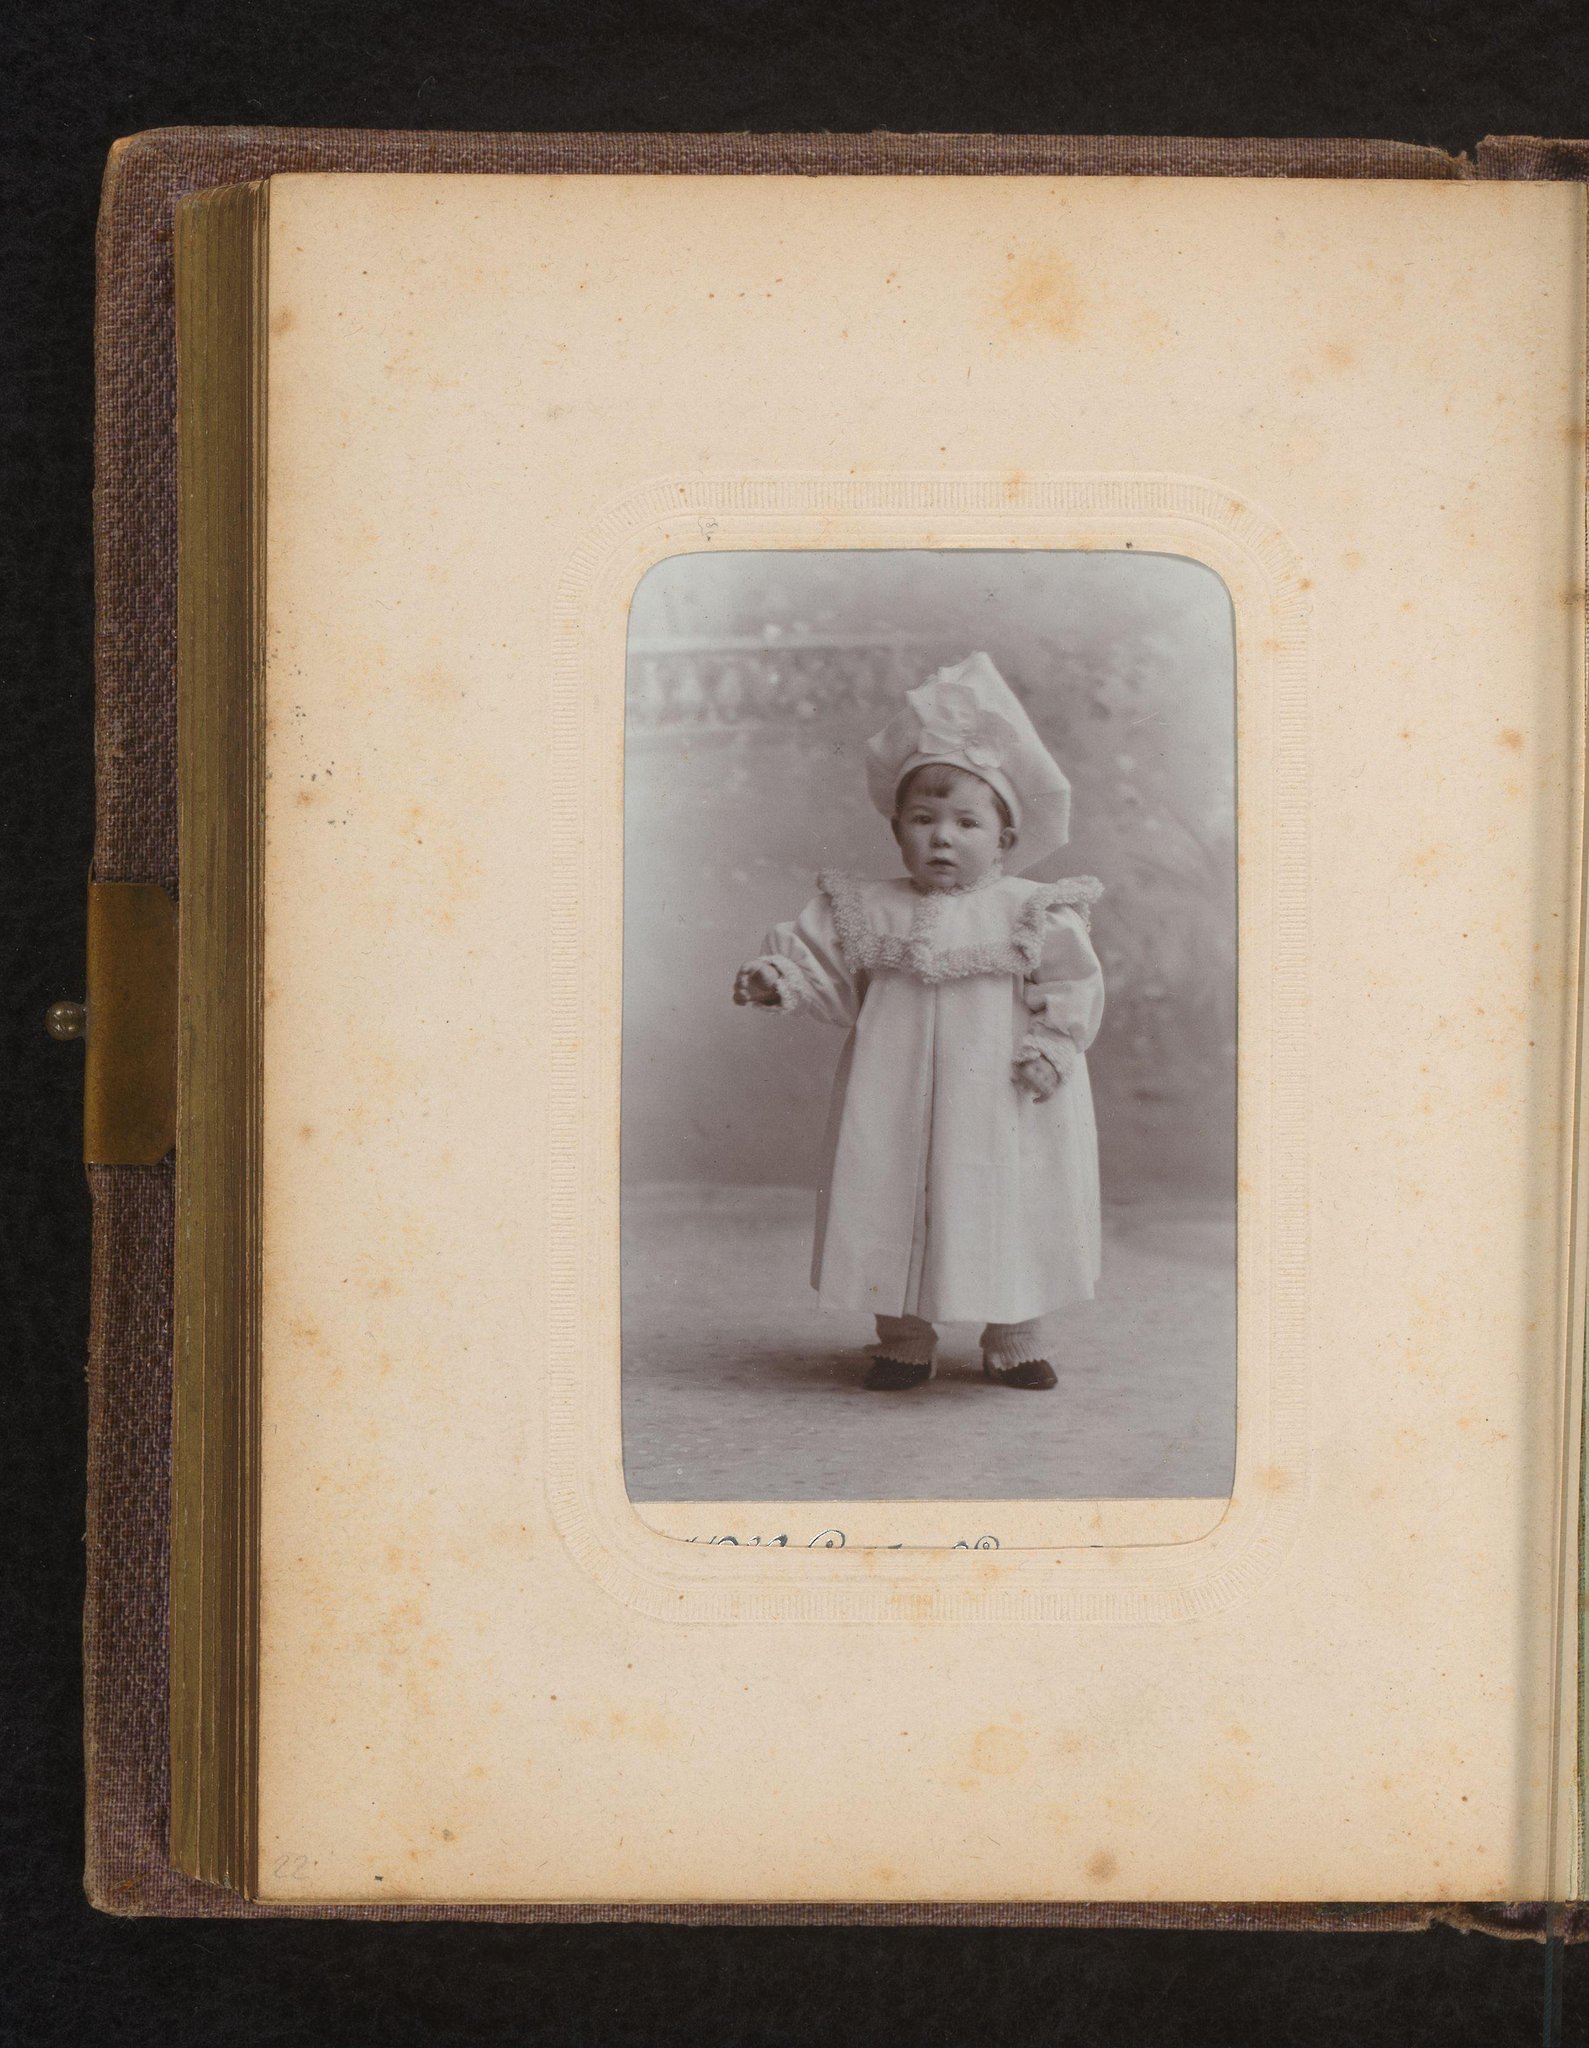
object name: album leaf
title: Portret van een peuter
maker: machiel hendricus laddé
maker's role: fotograaf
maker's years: 1866-1932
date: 1892-1906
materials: cardboard, photographic support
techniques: collodion silver print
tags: toddler, historical persons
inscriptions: inscription: ‘Photografie artistique/ M. H. Laddé/(...)/Amsterdam/ 57-59 Nieuwendijk’